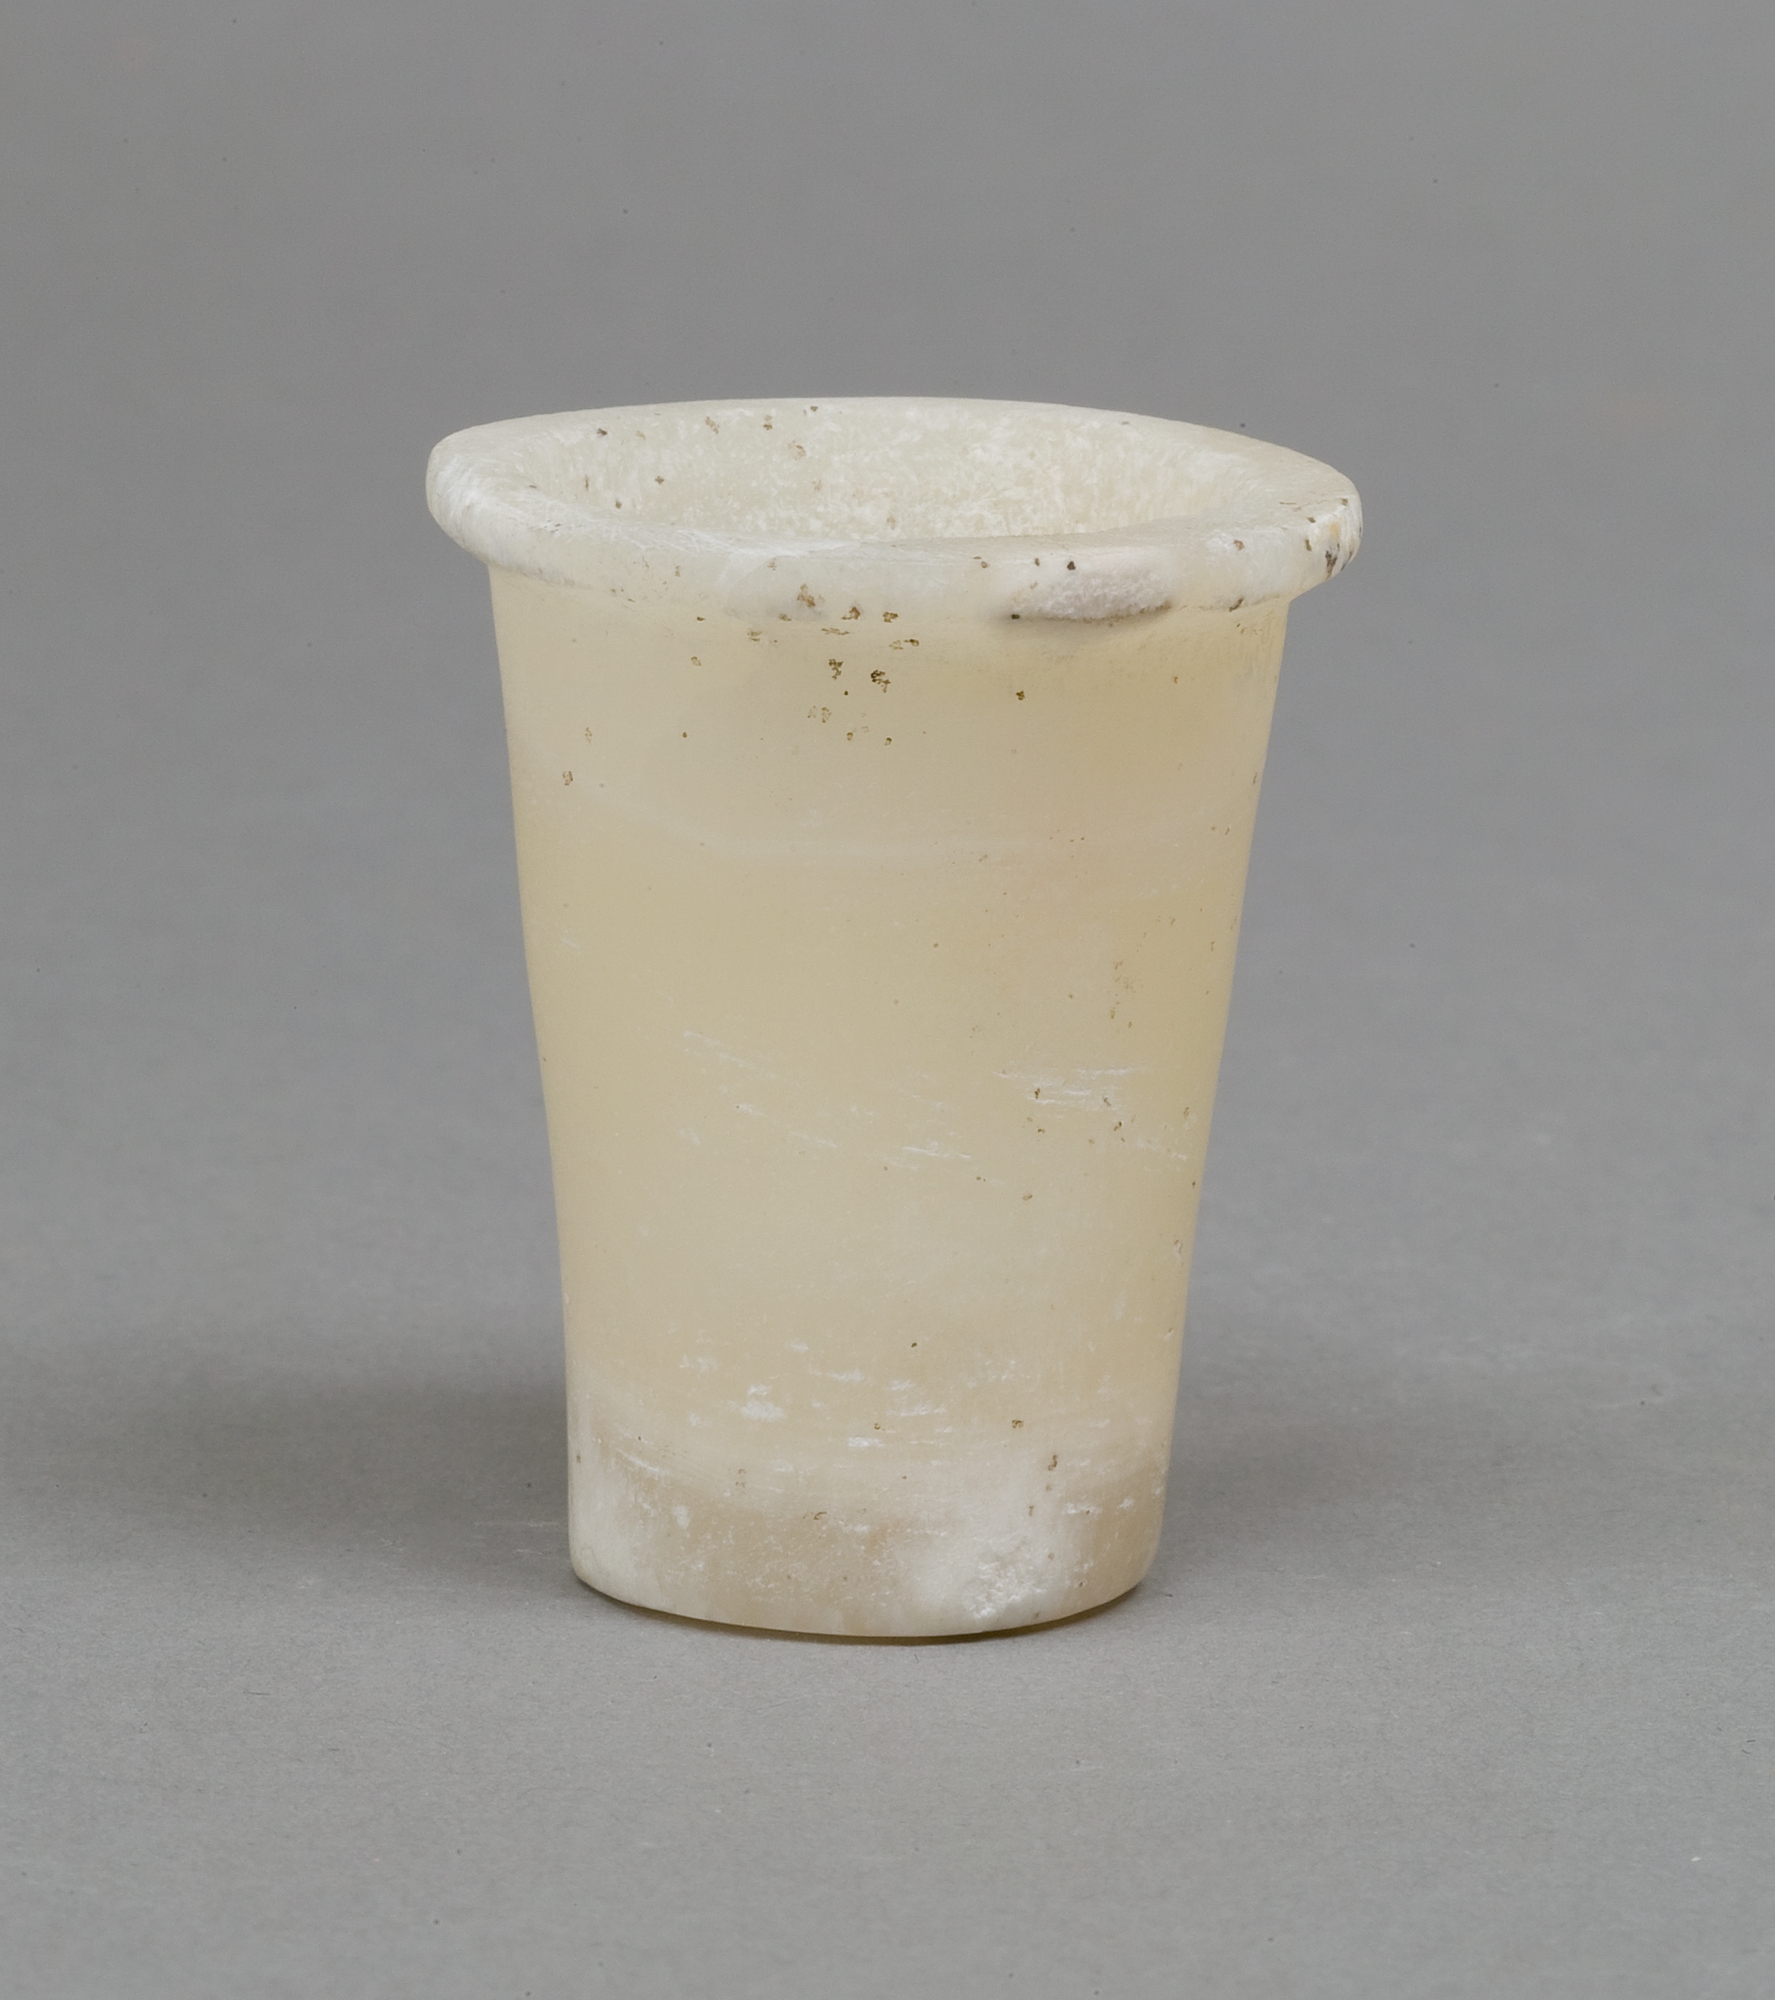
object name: jar, oil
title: Senwosret (?), Oil jar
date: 1950-1850 BCE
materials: stone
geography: egypt